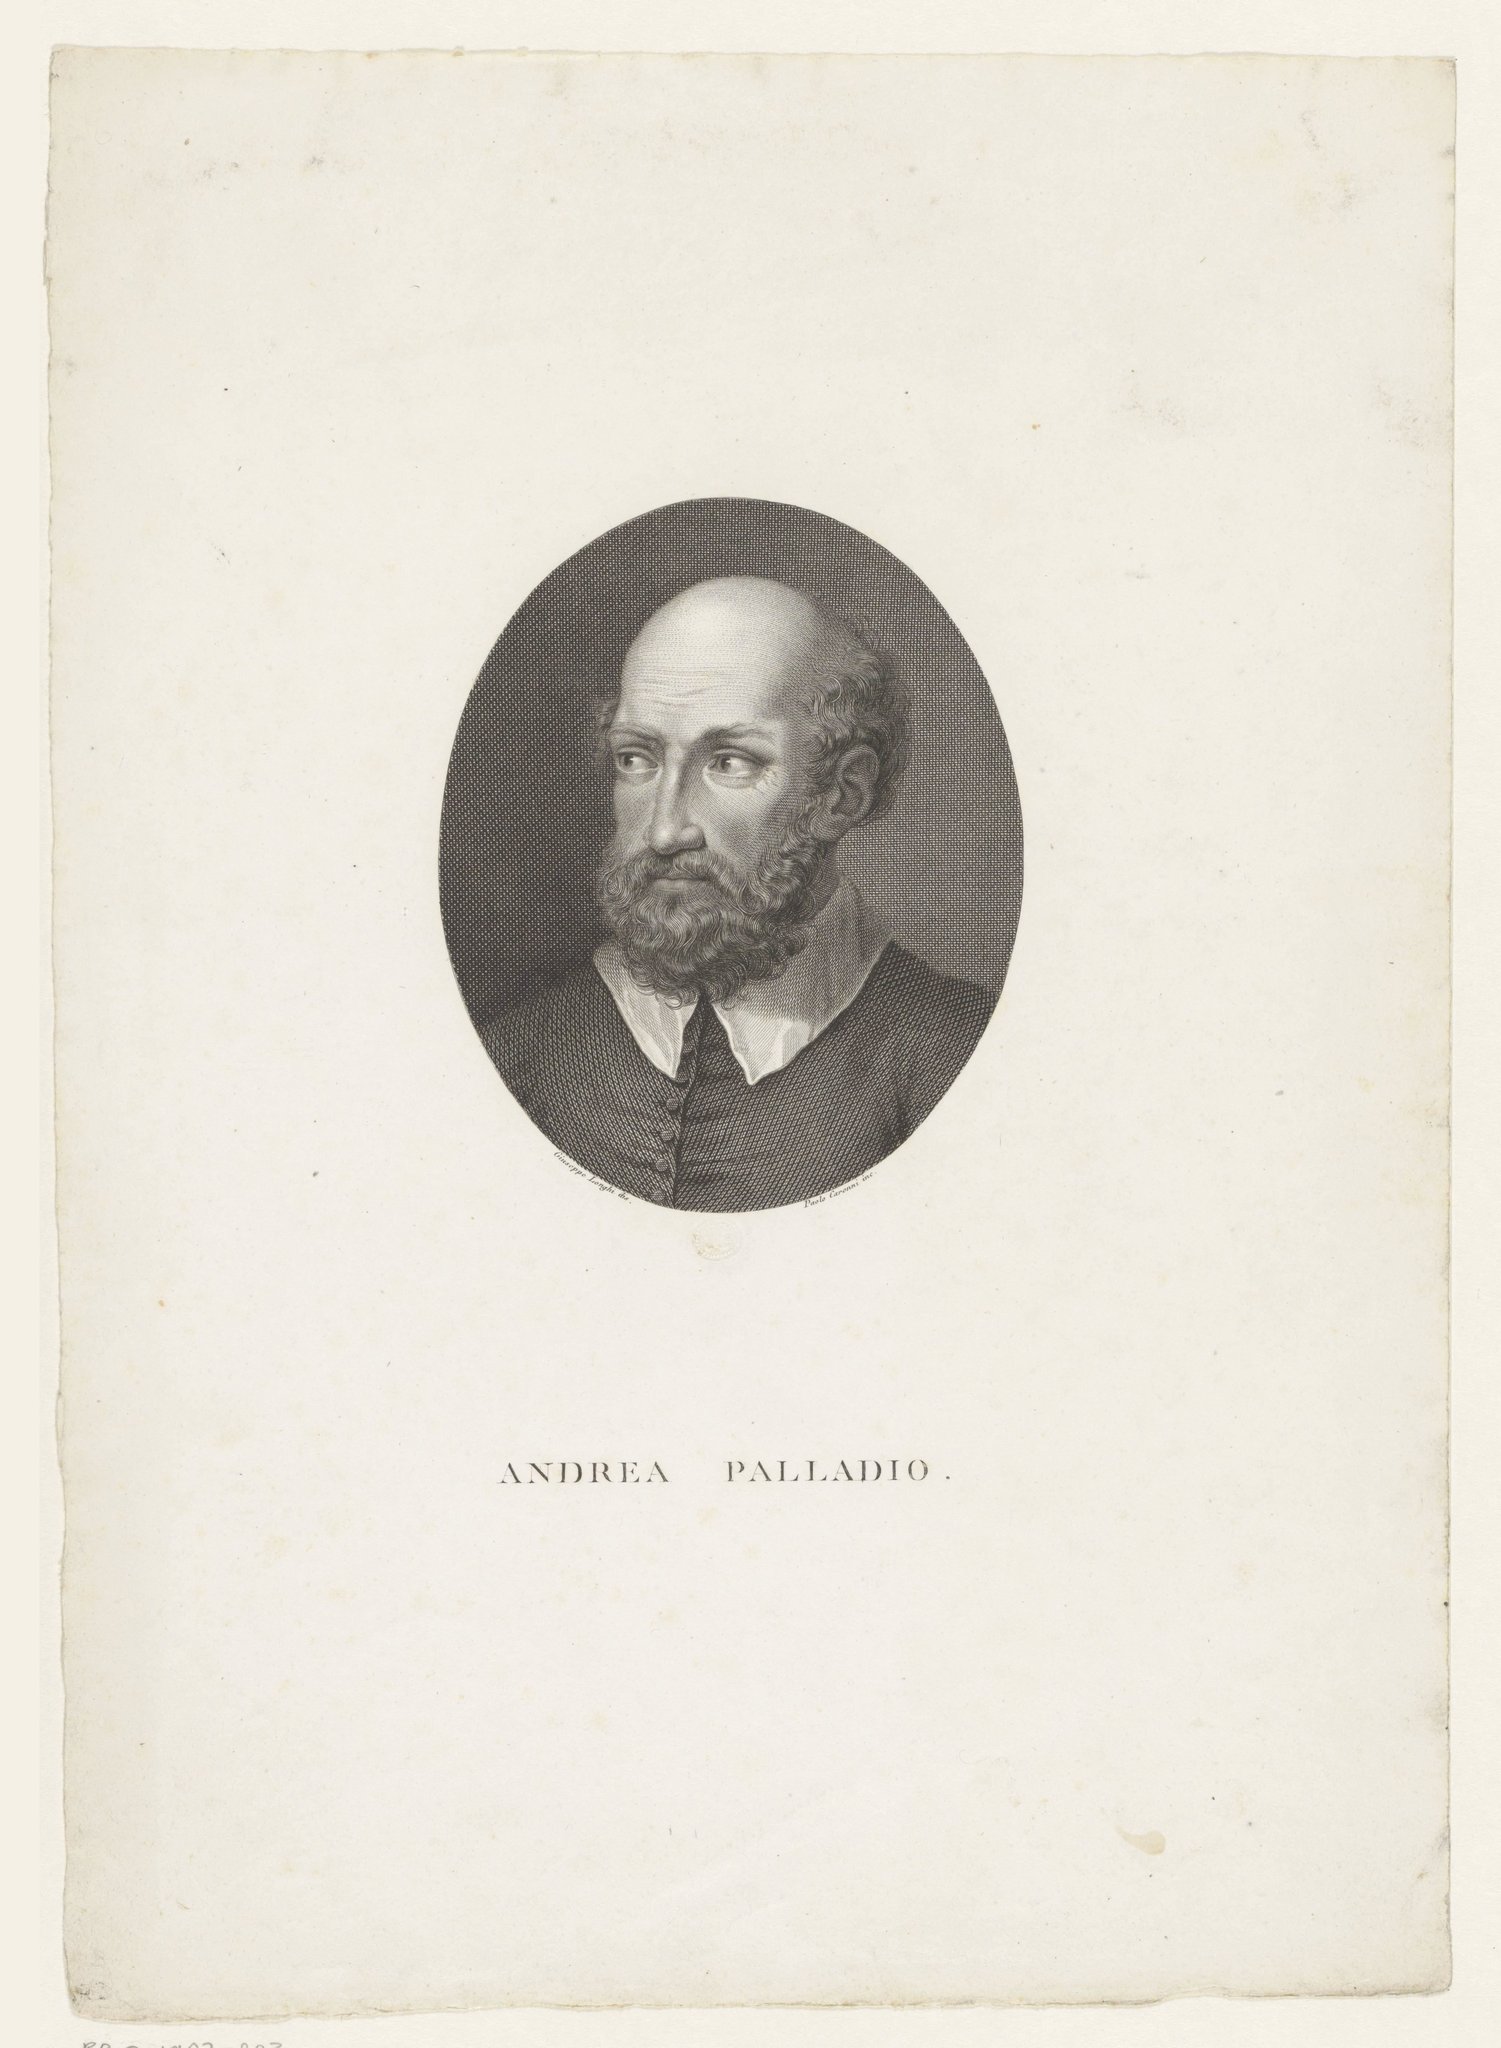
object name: print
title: Portret van architect Andrea Palladio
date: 1789-1842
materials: paper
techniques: engraving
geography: italy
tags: andrea palladio, historical persons, portrait, self-portrait of architect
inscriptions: collector's mark: Lugt 4187, collector's mark: Lugt 2228